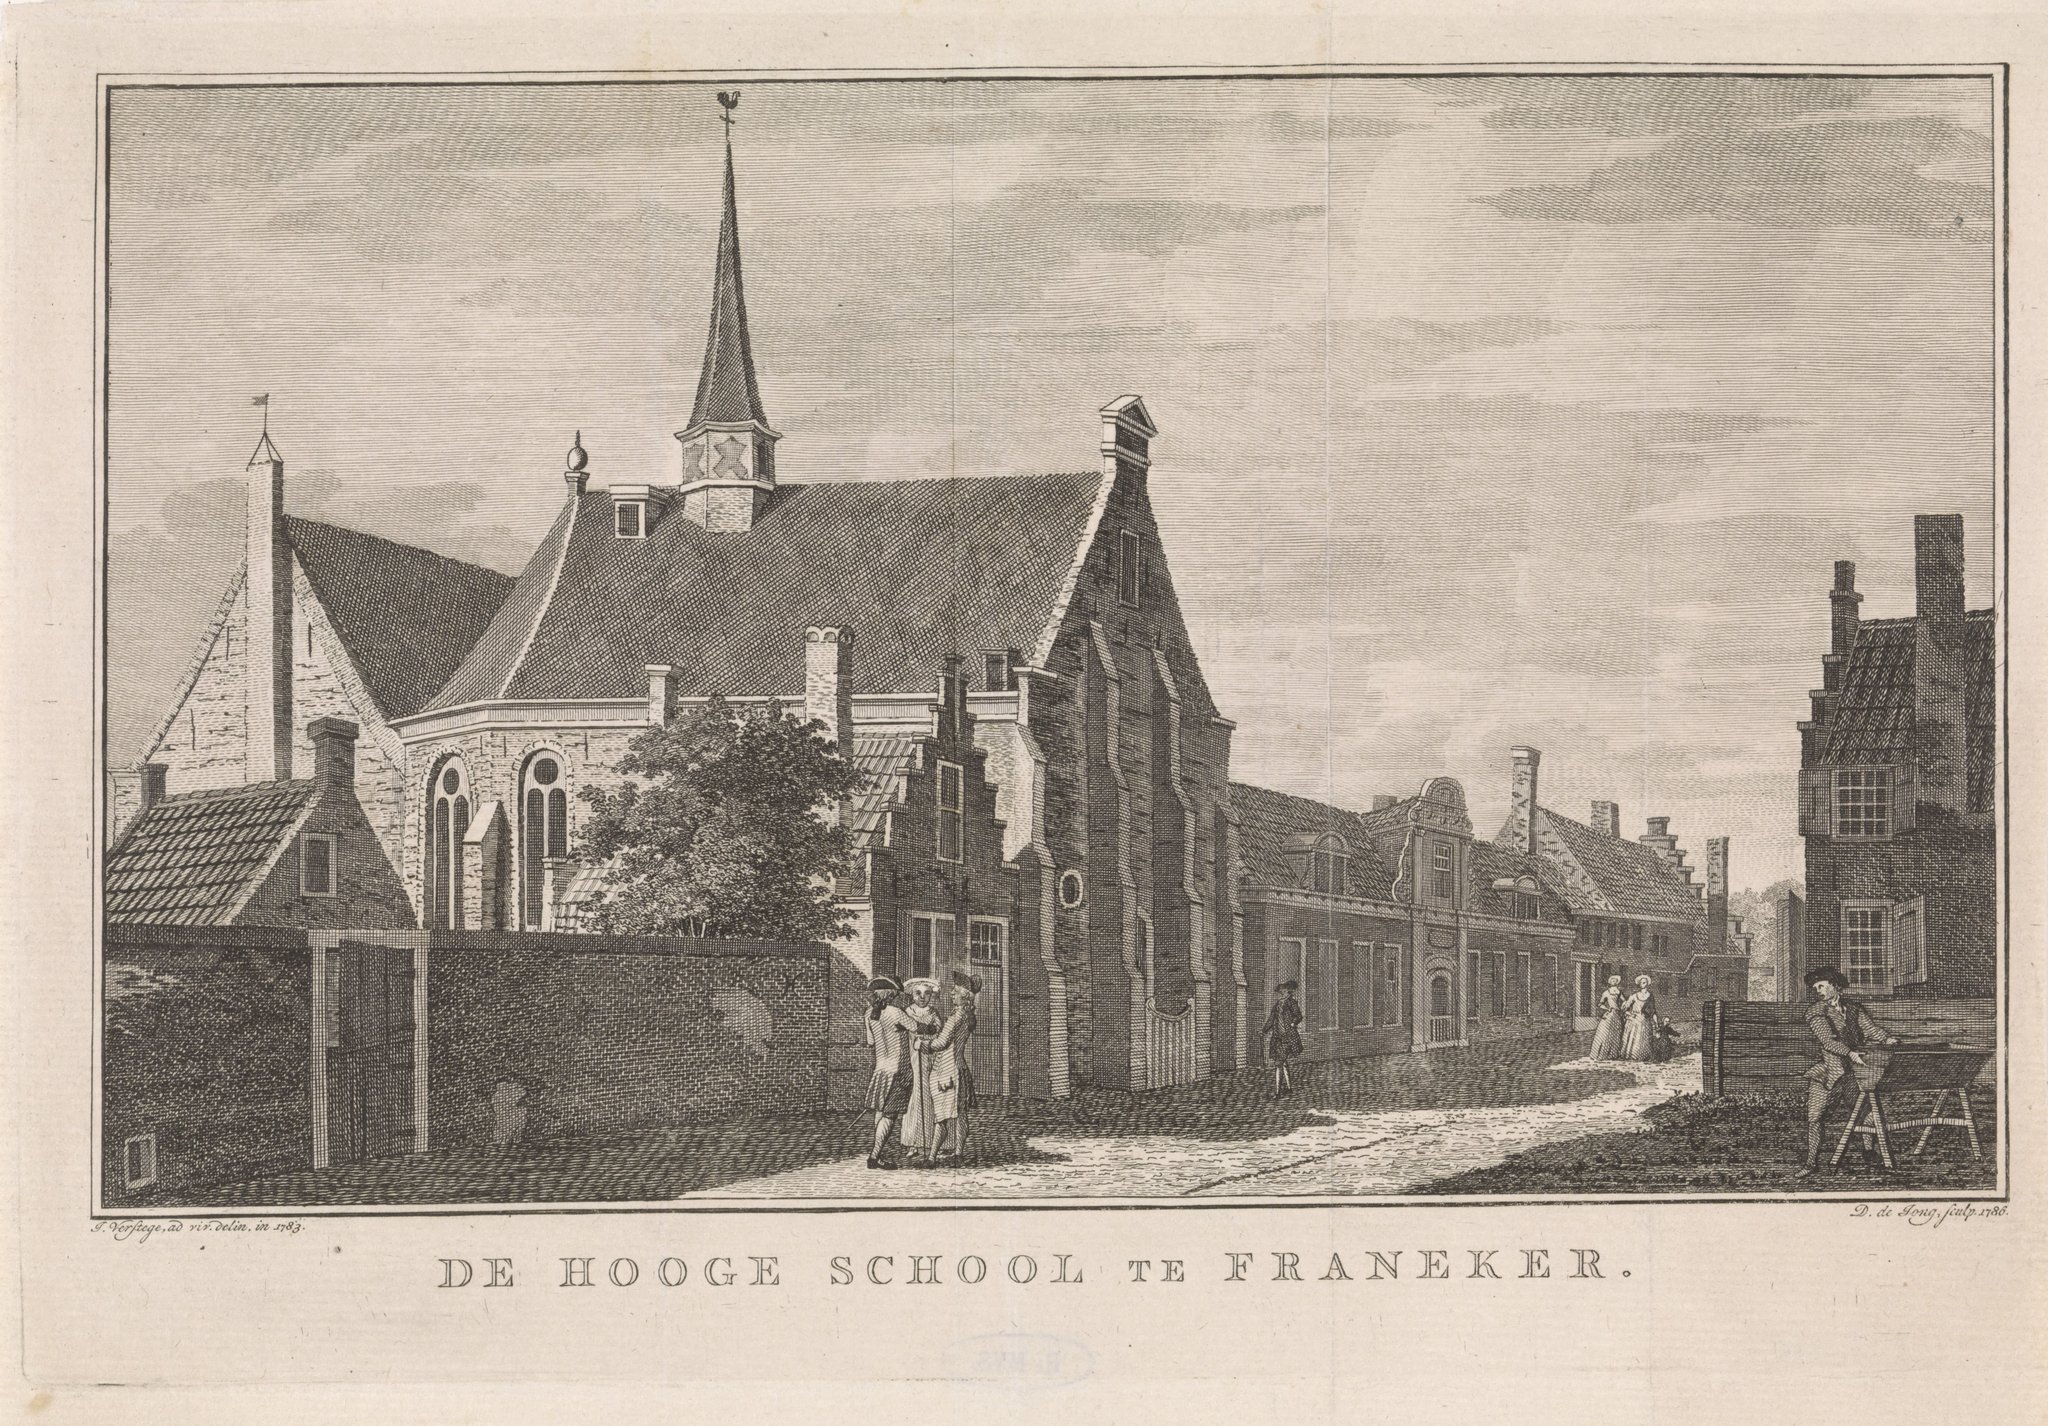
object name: book illustration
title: De Hooge school te Franeker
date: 1786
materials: paper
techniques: engraving, etching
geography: northern netherlands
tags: university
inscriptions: collector's mark: Lugt 2228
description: Gezicht op de universiteit te Franeker (gevestigd in het voormalige Kruisherenklooster te Franeker). Op straat diverse figuren. In de marge een onderschrift in het Nederlands.